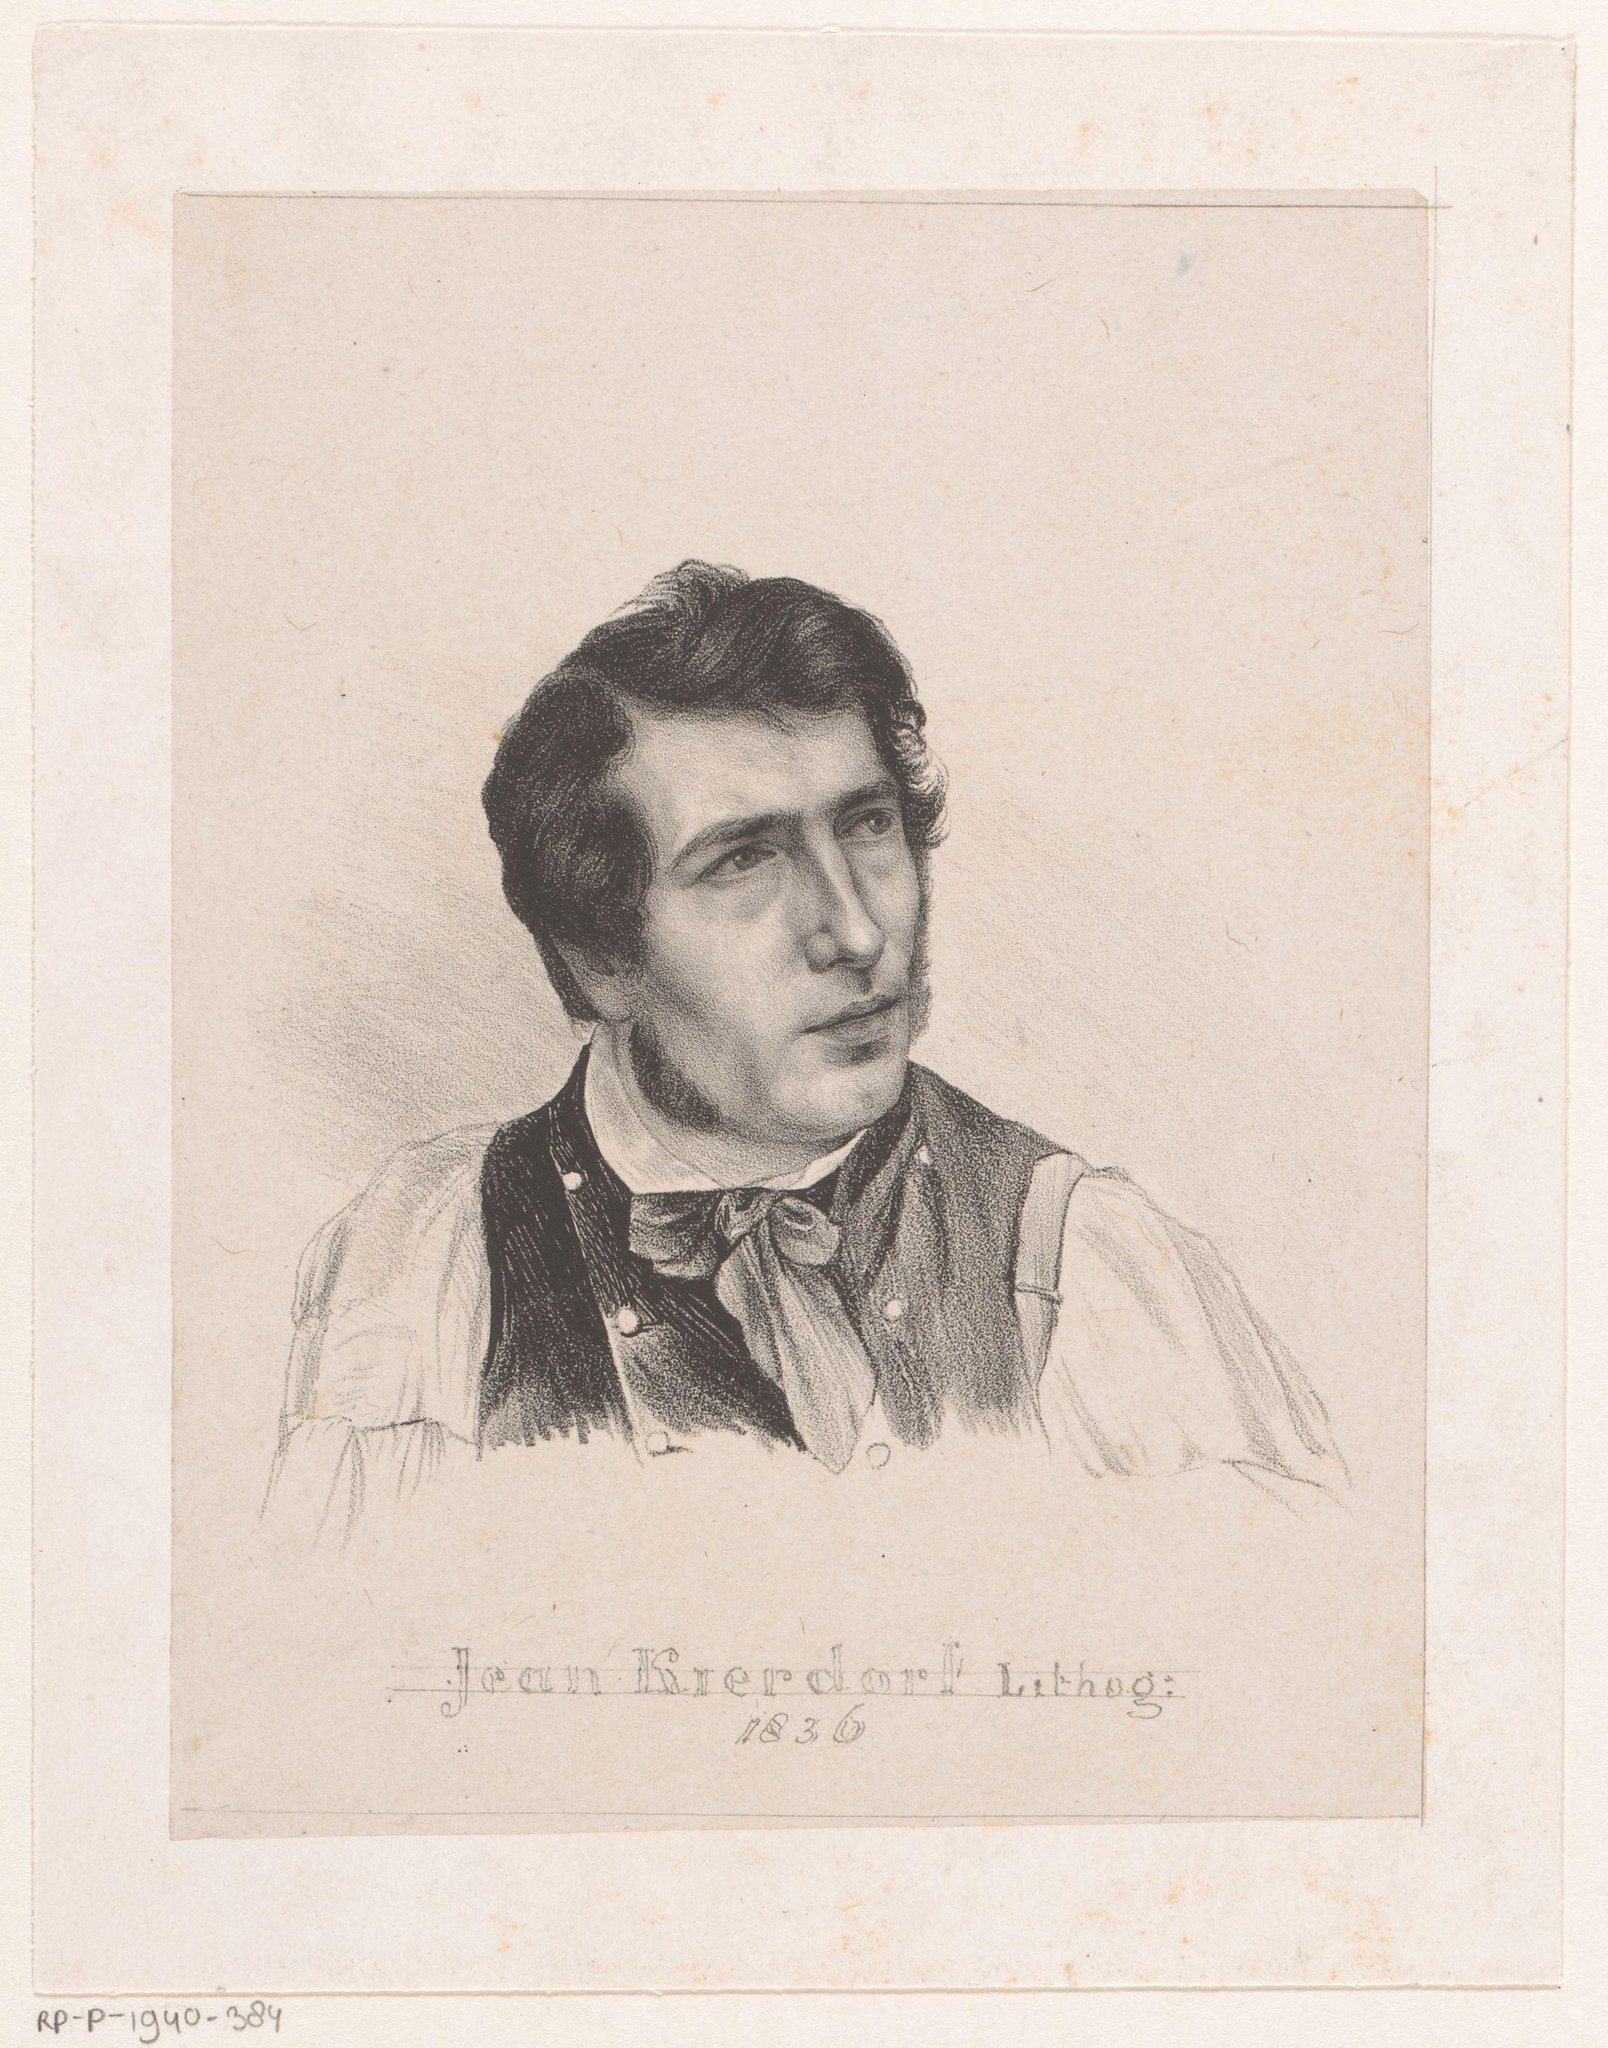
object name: print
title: Zelfportret van Jean Kierdorff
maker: jean matthieu kierdorff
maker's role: print maker, printer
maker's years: 1803-1882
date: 1836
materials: paper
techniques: lithograph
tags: portrait, self-portrait of artist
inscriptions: collector's mark: Lugt 2760, inscription: ‘Jean Kierdorf lithog: / 1836’, collector's mark: Lugt 2228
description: De geportretteerde kijkt naar rechtsboven.